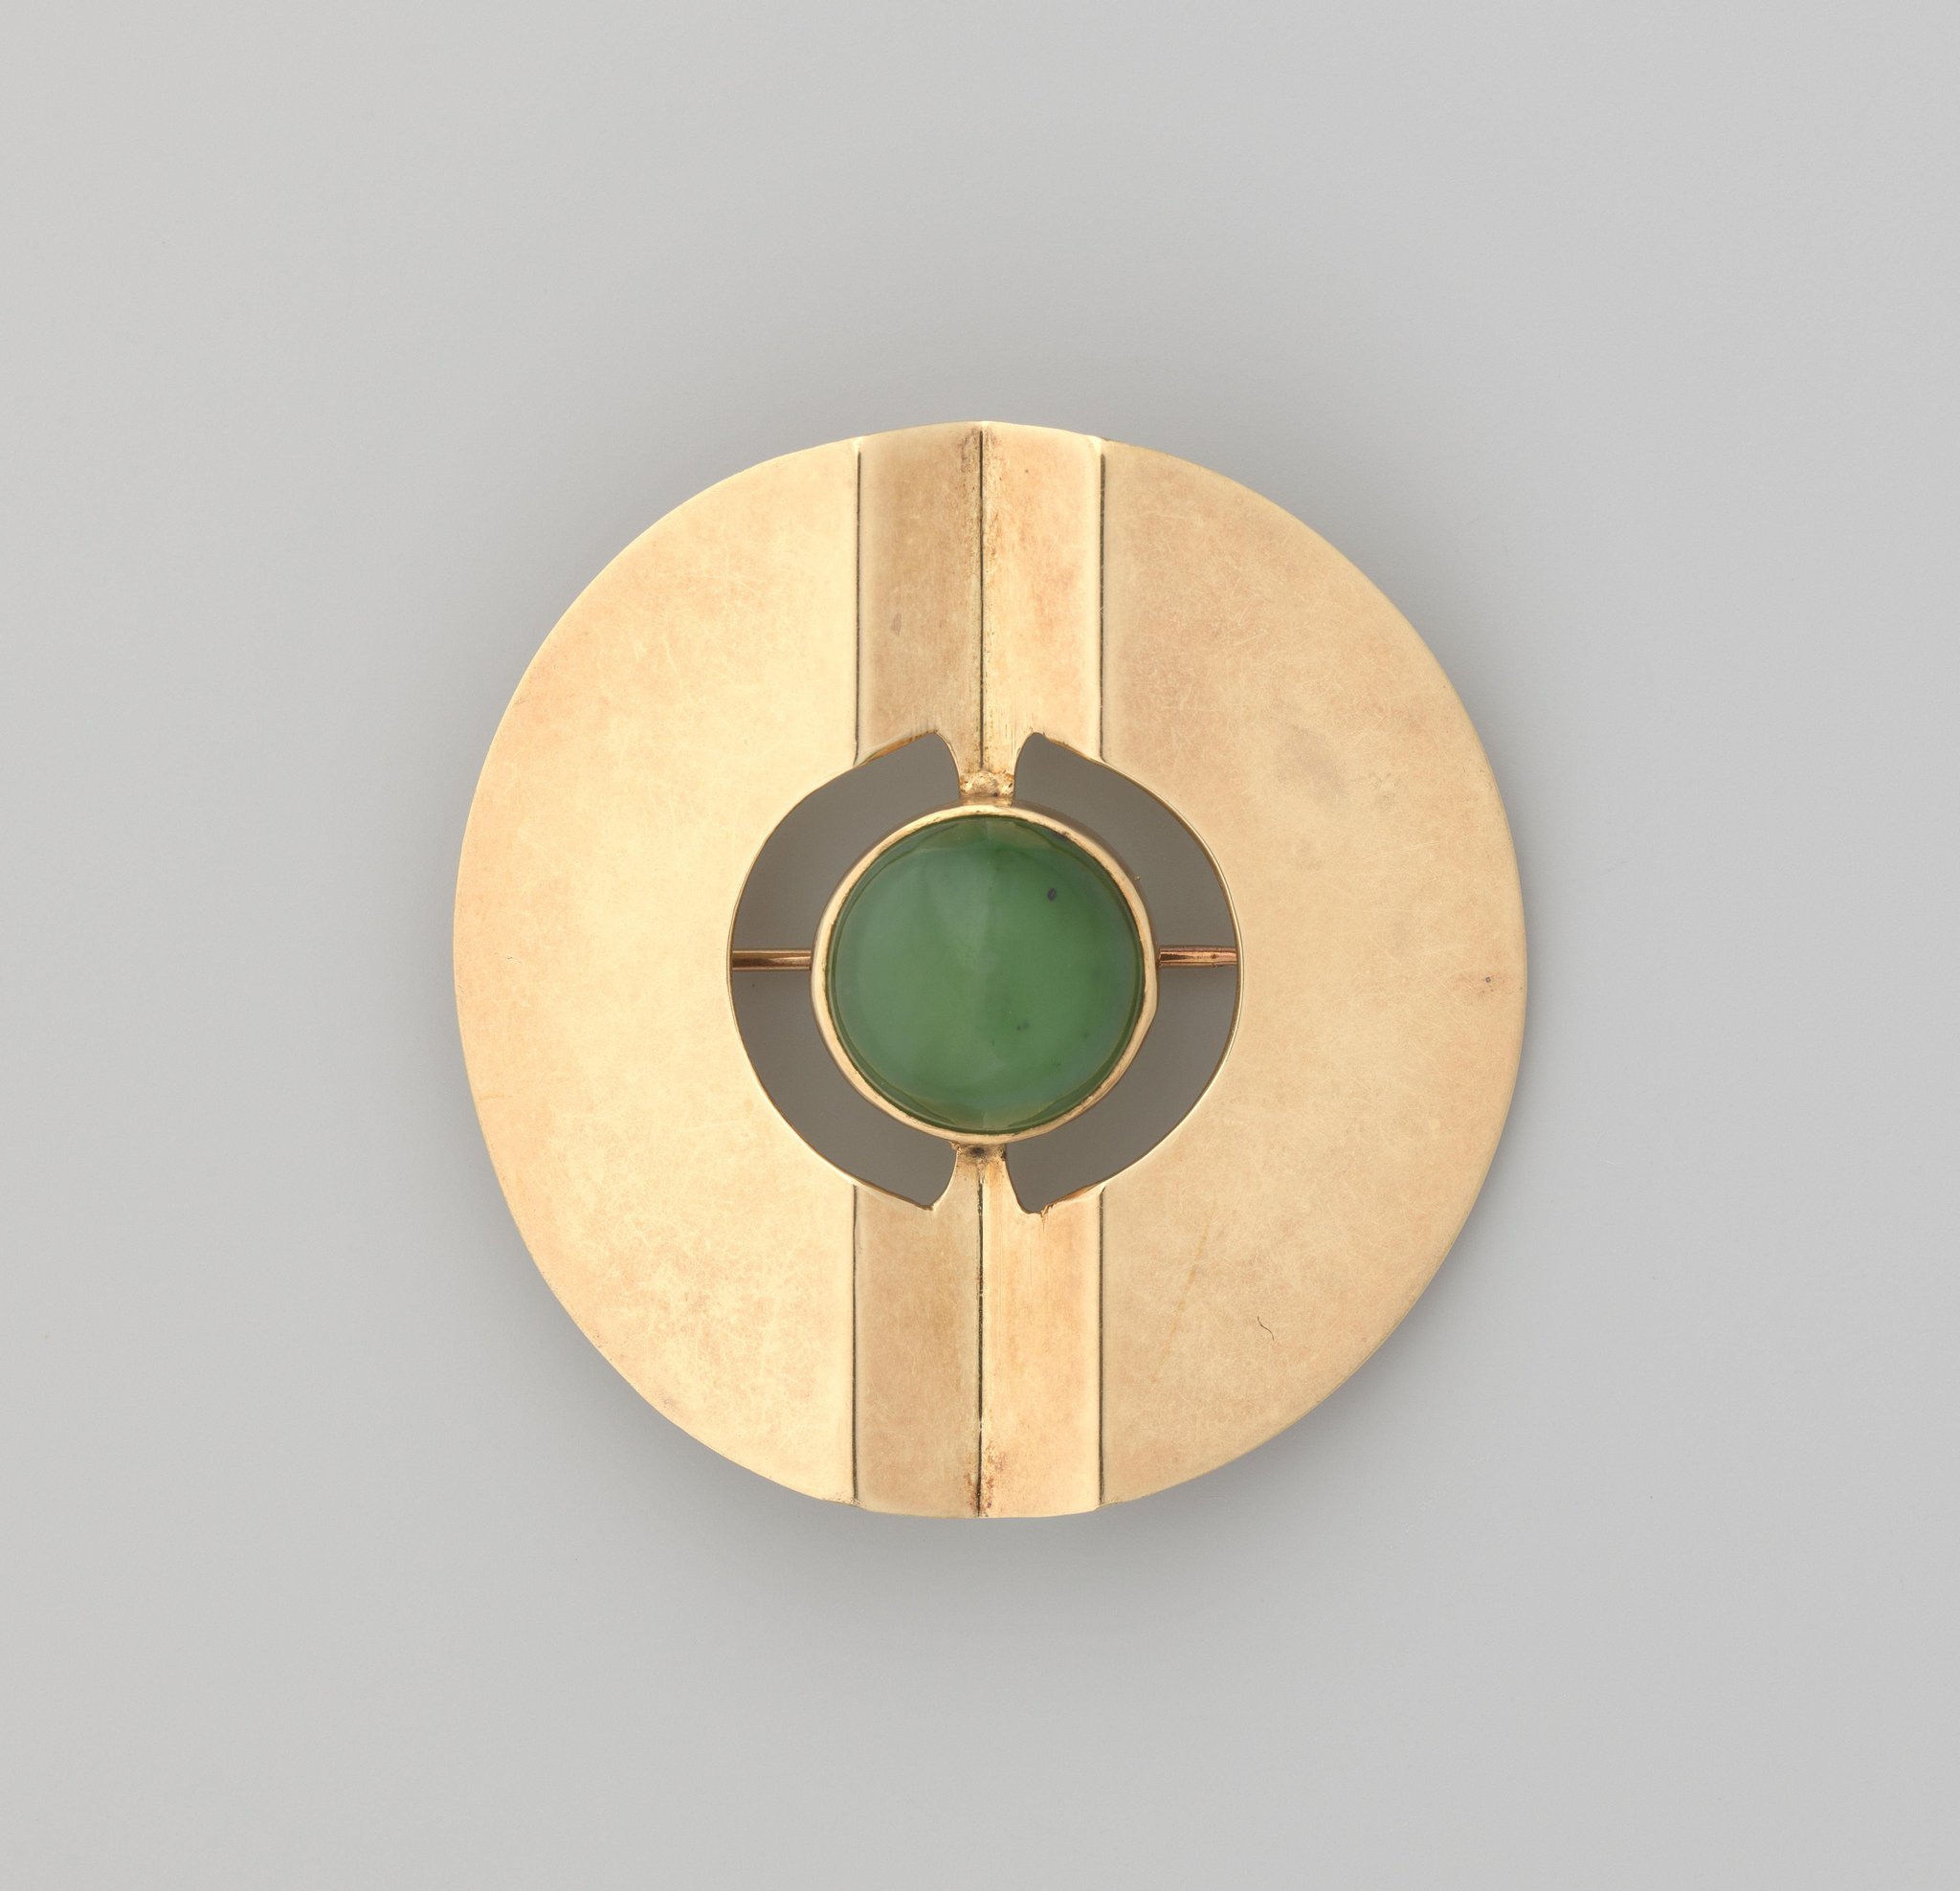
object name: brooch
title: Ronde broche van goud met centraal een ronde nefriet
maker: Anonymous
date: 1971-1972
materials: gold, jade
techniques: grinding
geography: netherlands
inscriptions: alloy mark: ‘eikenblad 585’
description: Ronde broche van goud met centraal een rond cabochon geslepen nefriet, vorzien van kogelsluiting.